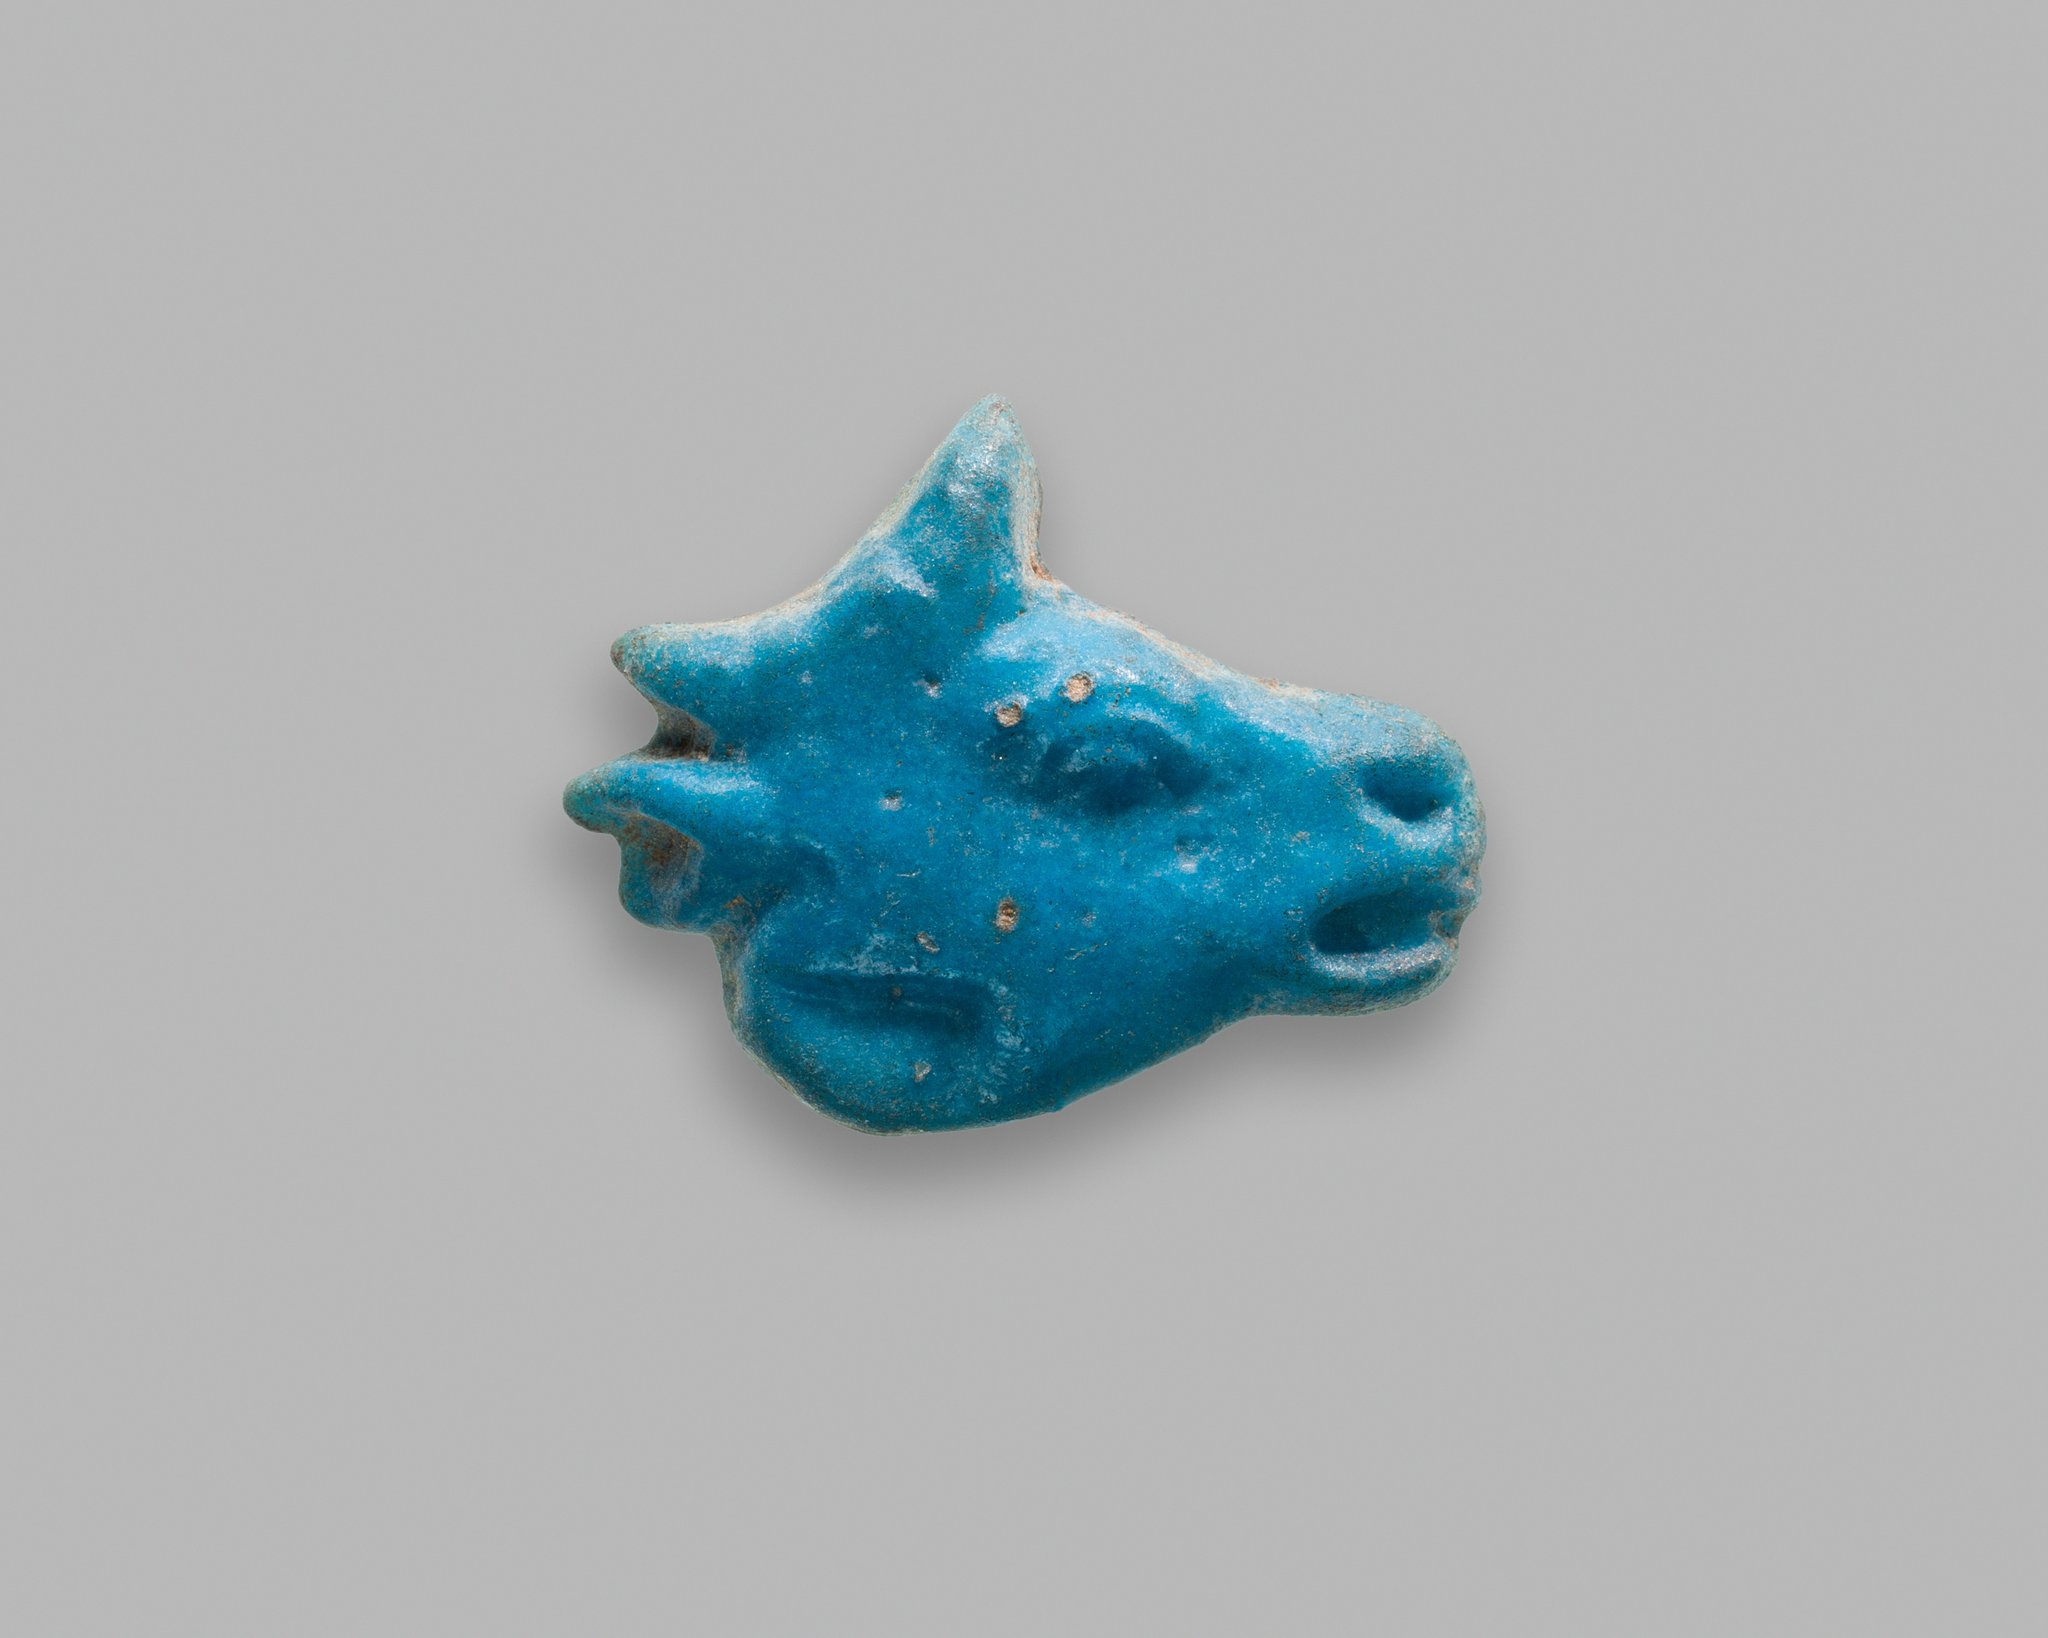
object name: amulet, ox head, foundation deposit, tawosret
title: Foundation Deposit Plaque in the Form of an Ox Head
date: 1188-1186 BCE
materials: faience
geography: egypt